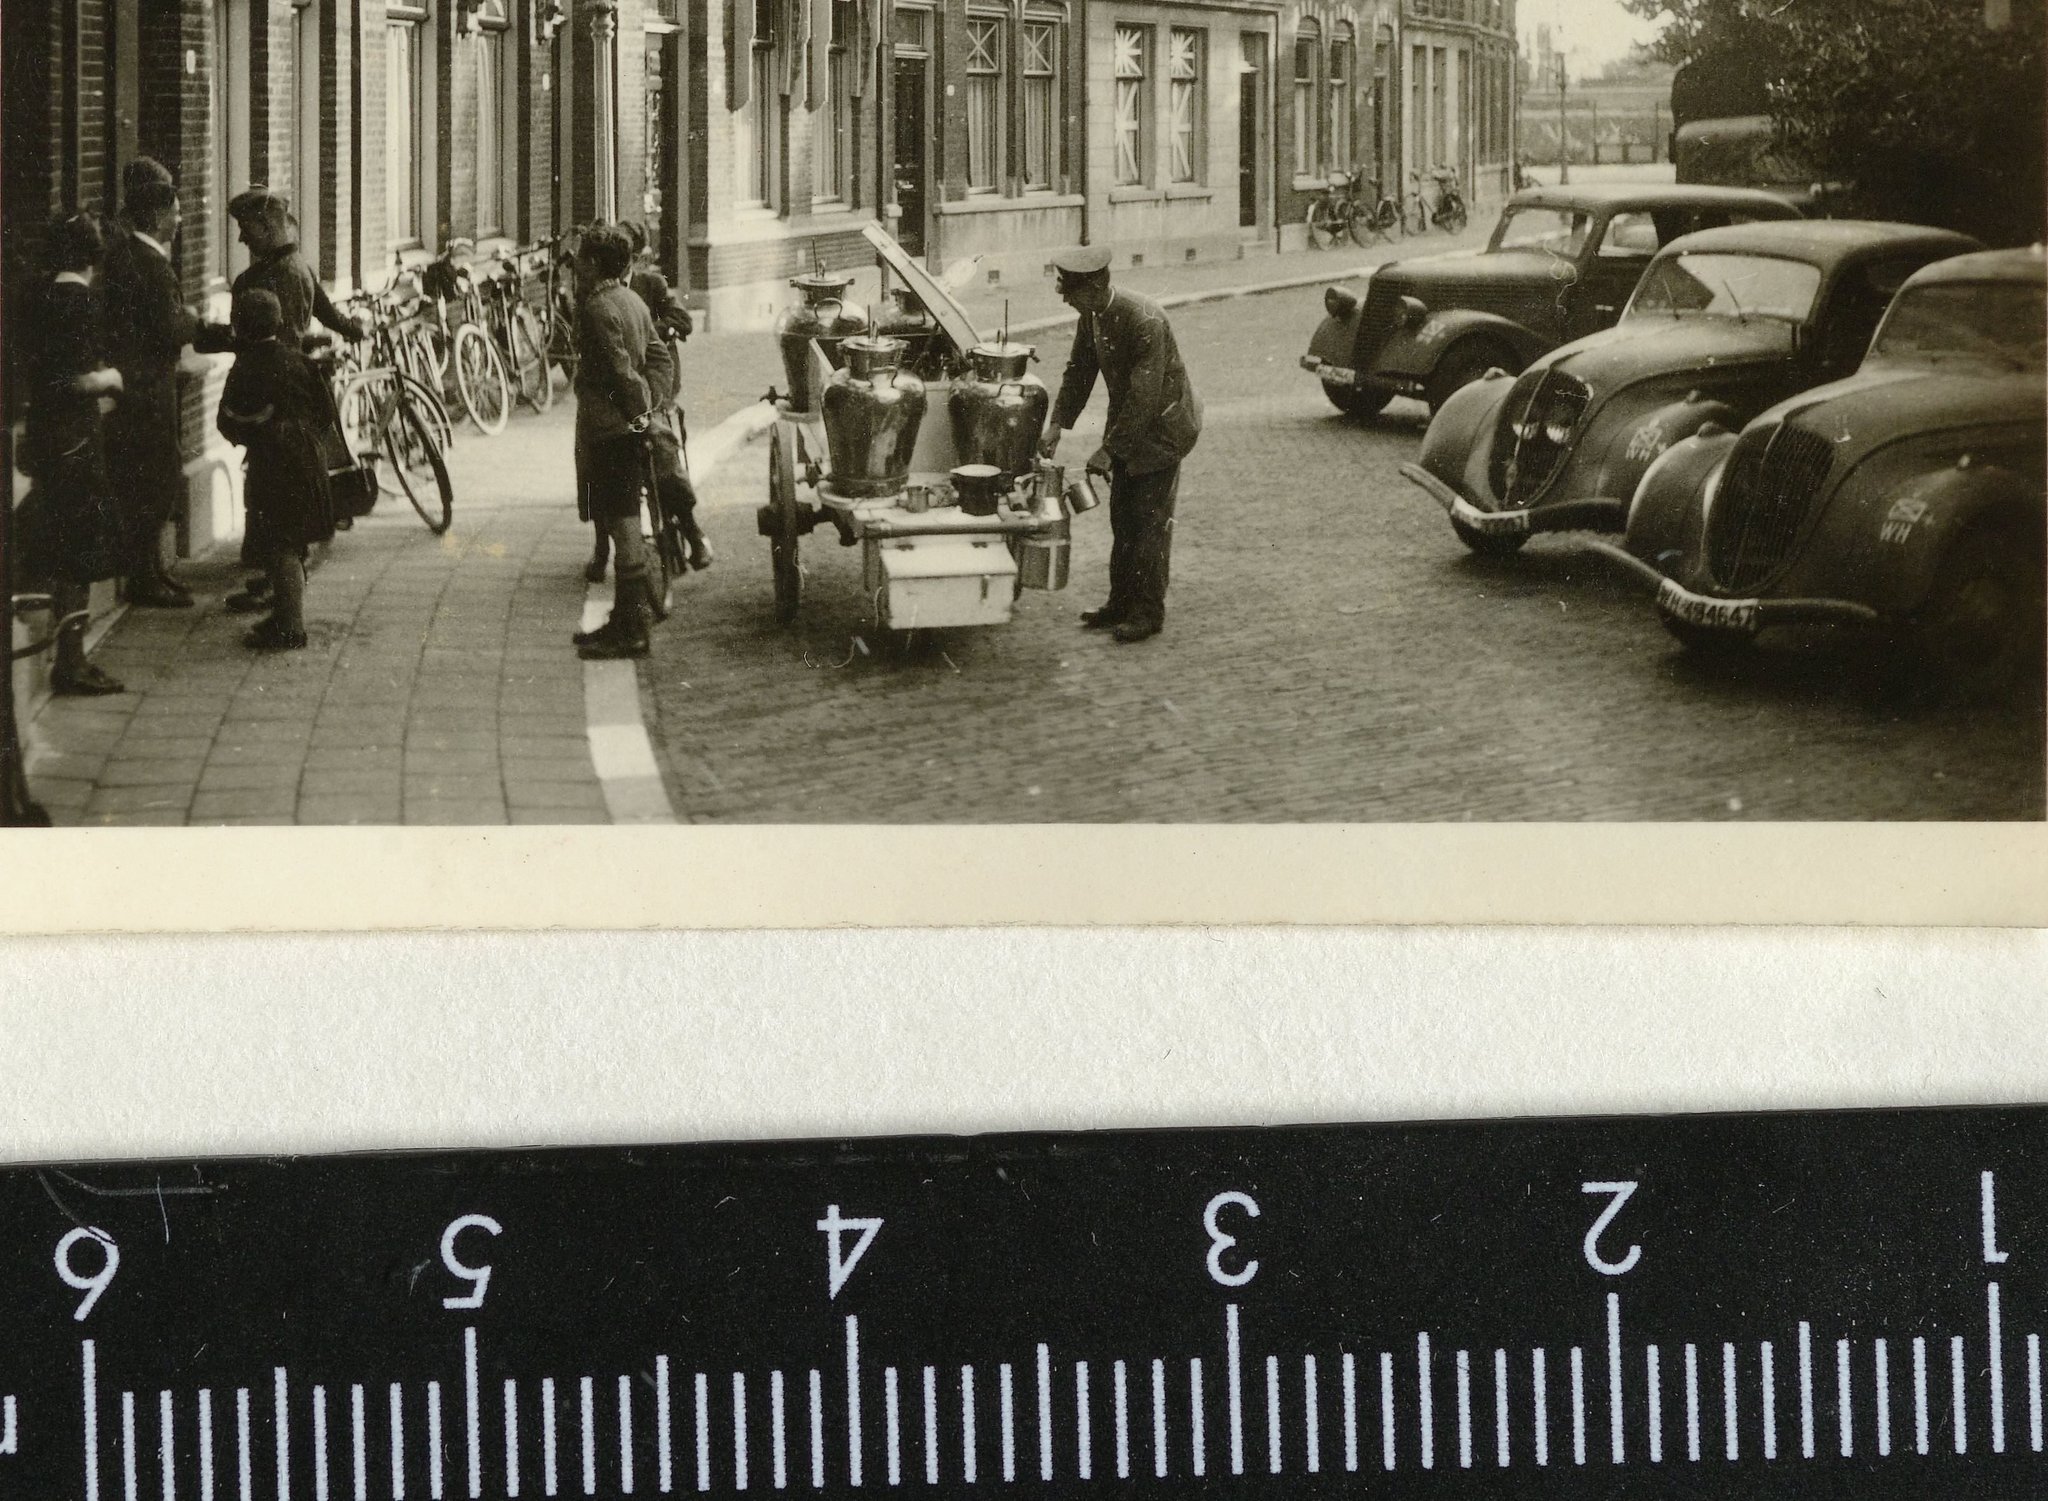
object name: photograph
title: De melkboer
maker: Anonymous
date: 1909-1940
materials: photographic support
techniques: gelatin silver print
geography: dordrecht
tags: occupier and civilians, occupation ~ war, transportation of milk, dordrecht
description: De melkboer op de Rozenhof in Dordrecht. Achterop staat: onleesbaar im Dordrecht (Holland) im Sept. 1940